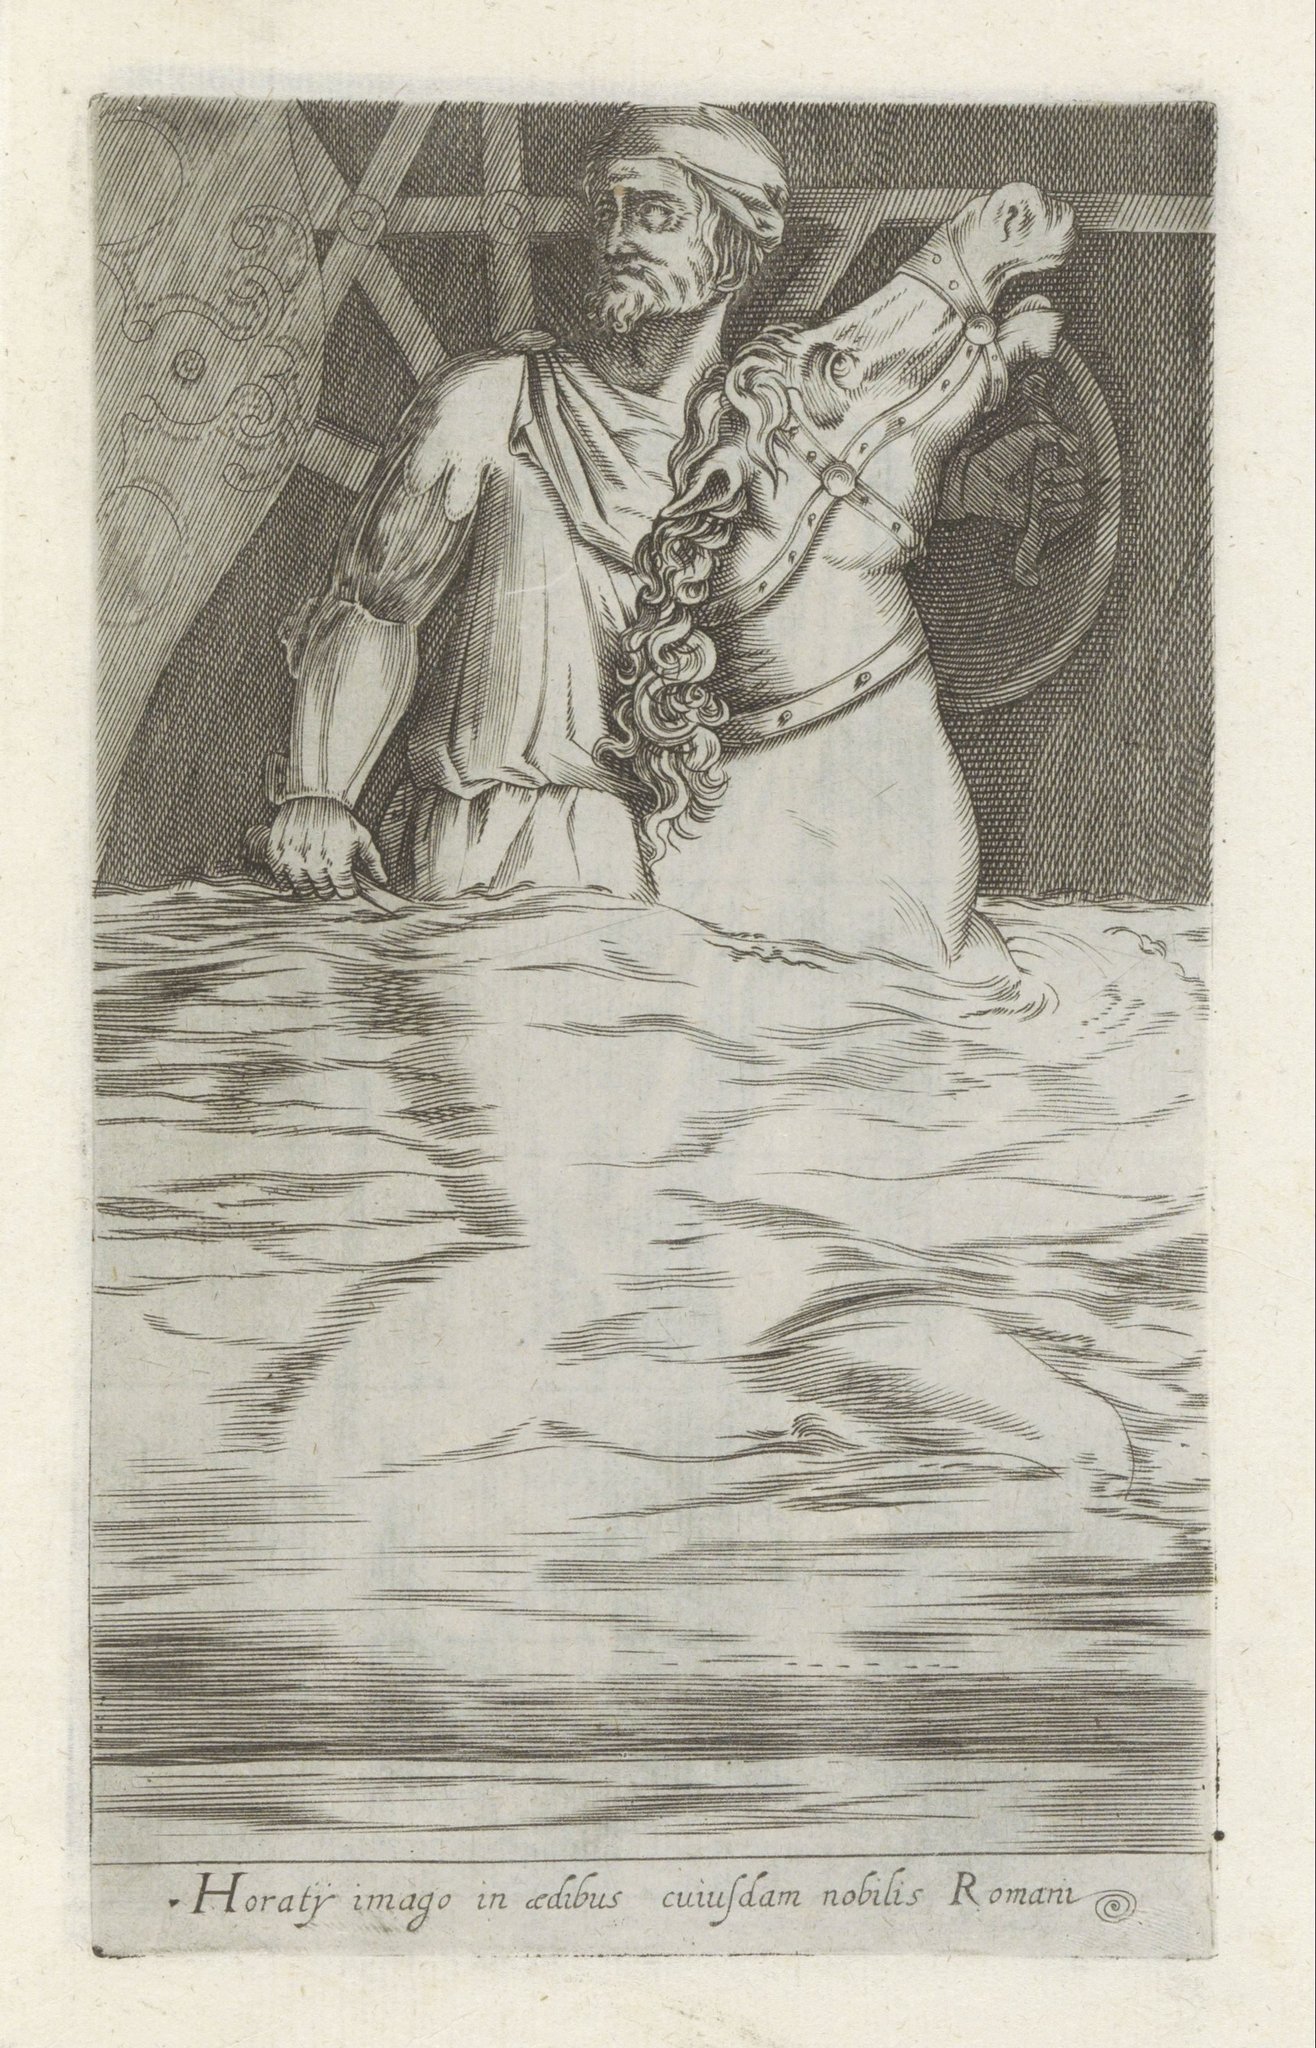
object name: print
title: Antiquarum statuarum urbis Romae quae in publicis locis visuntur icones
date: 1584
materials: paper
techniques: engraving, intaglio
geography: rome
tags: piece of sculpture, reproduction of a piece of sculpture, horatius cocles at the pons sublicius: single-handed he keeps the etruscans at bay while the bridge is broken down by the romans behind him; he escapes by jumping into the tiber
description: Deze prent maakt deel uit van een set van 79 prenten (+ titelprent) met voorstellingen van antieke sculpturen in Rome.